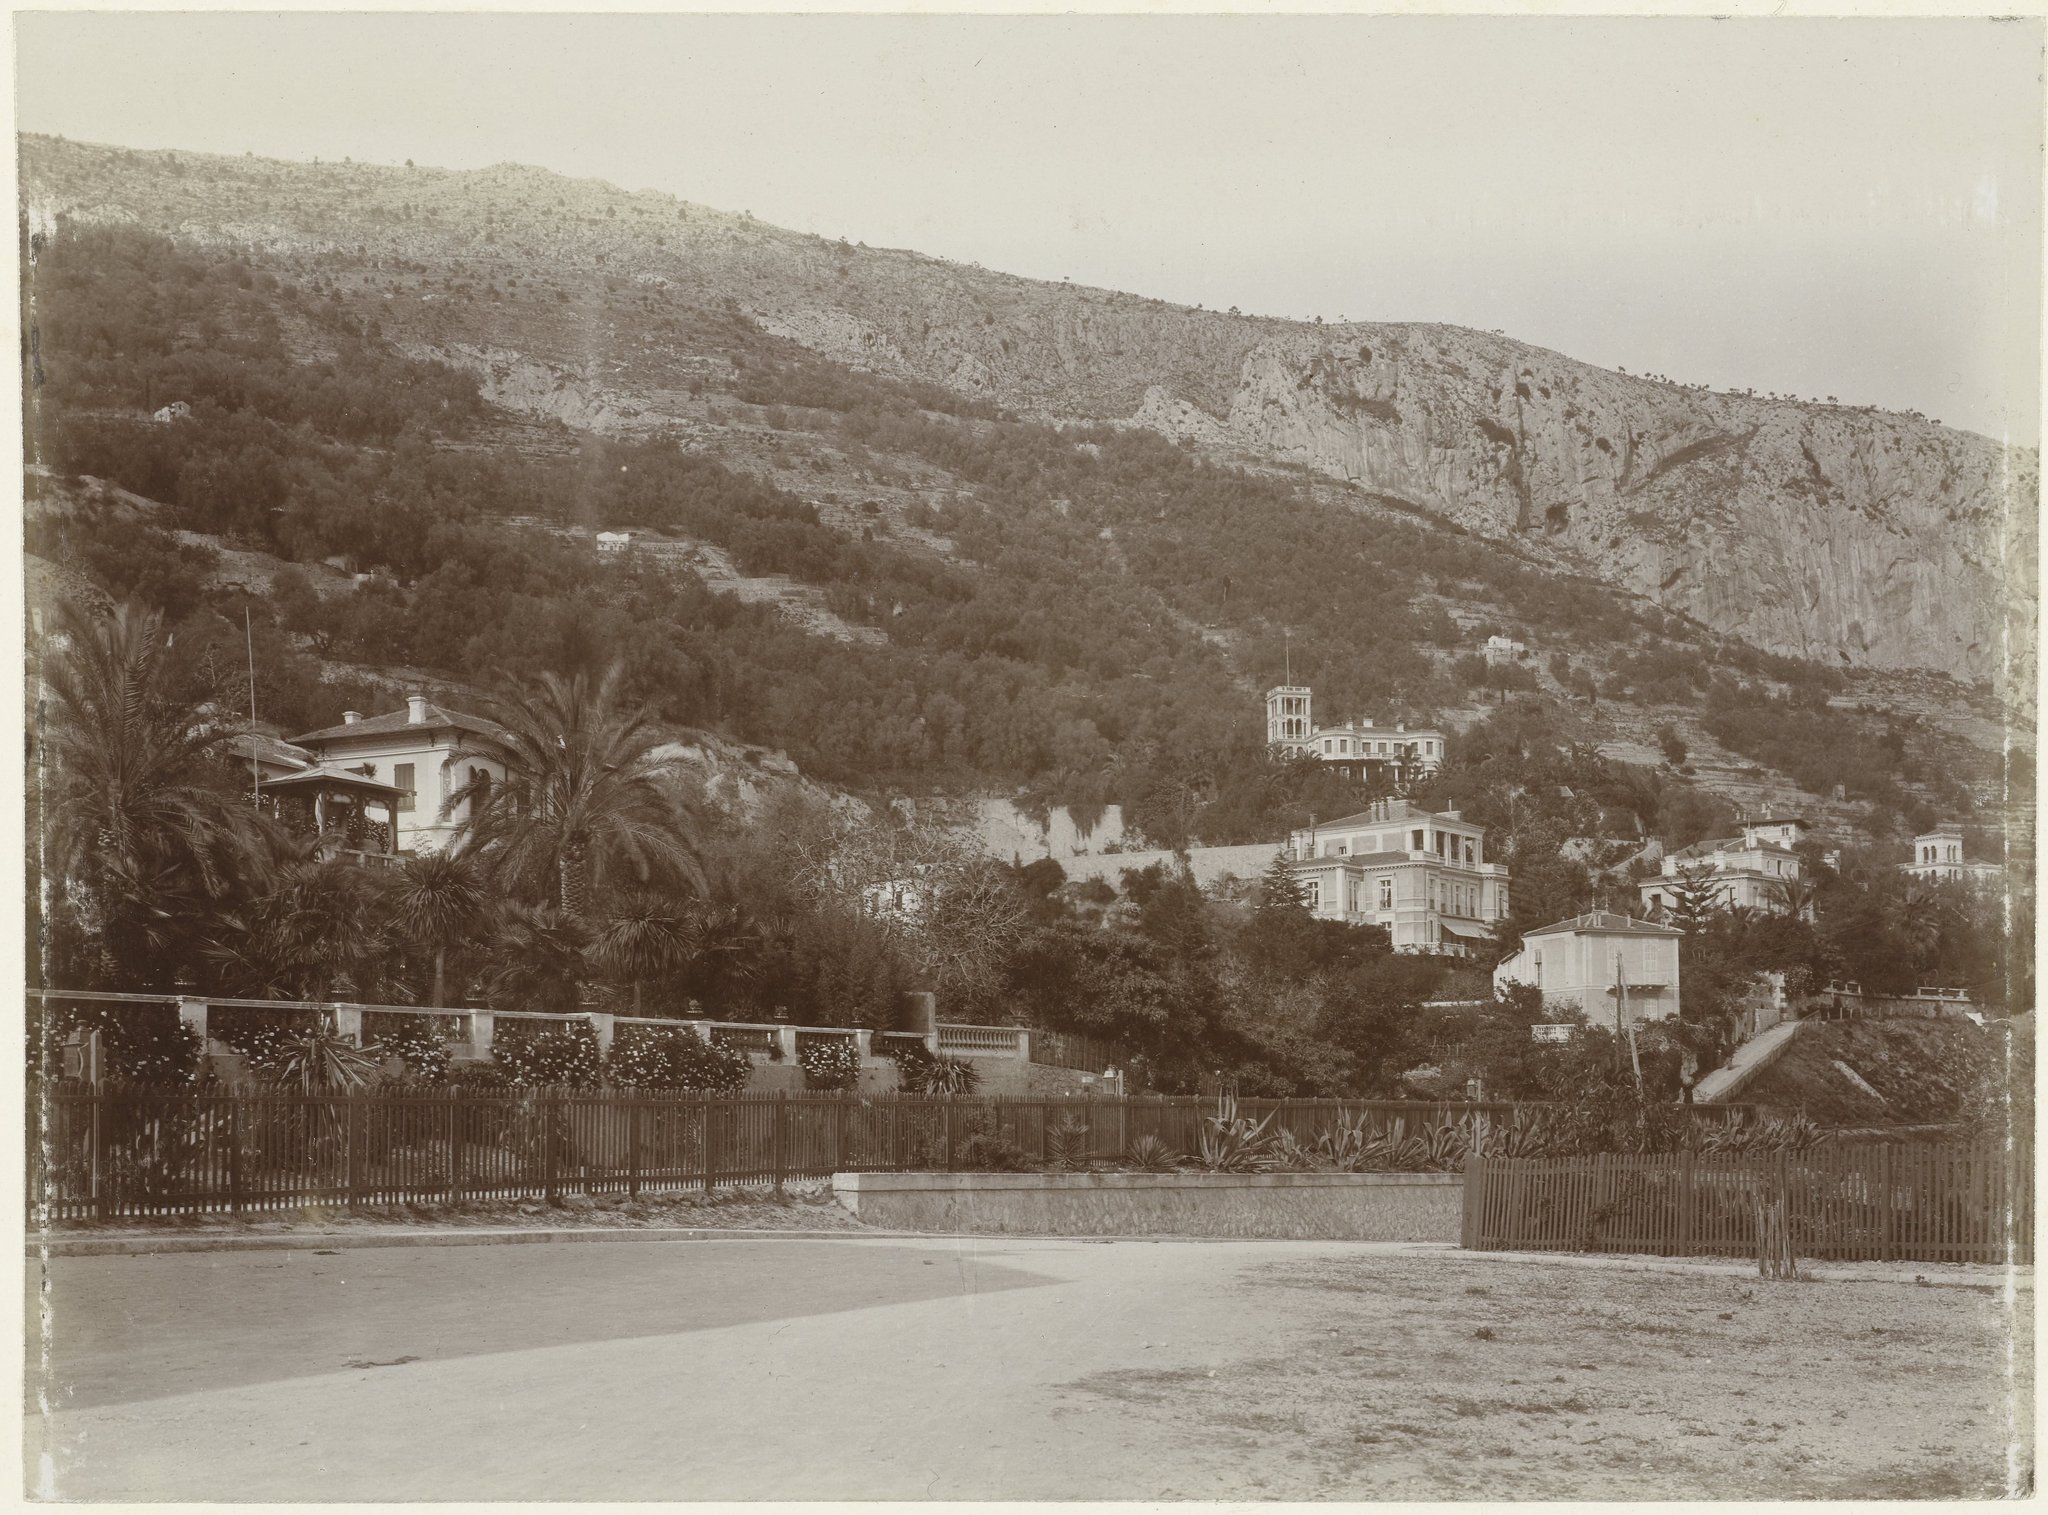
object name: photograph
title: Gezicht op Villa Louise van het station.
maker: henry pauw van wieldrecht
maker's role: fotograaf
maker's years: 1863-1912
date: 1886-1896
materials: cardboard, photographic support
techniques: albumen print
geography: france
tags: menton